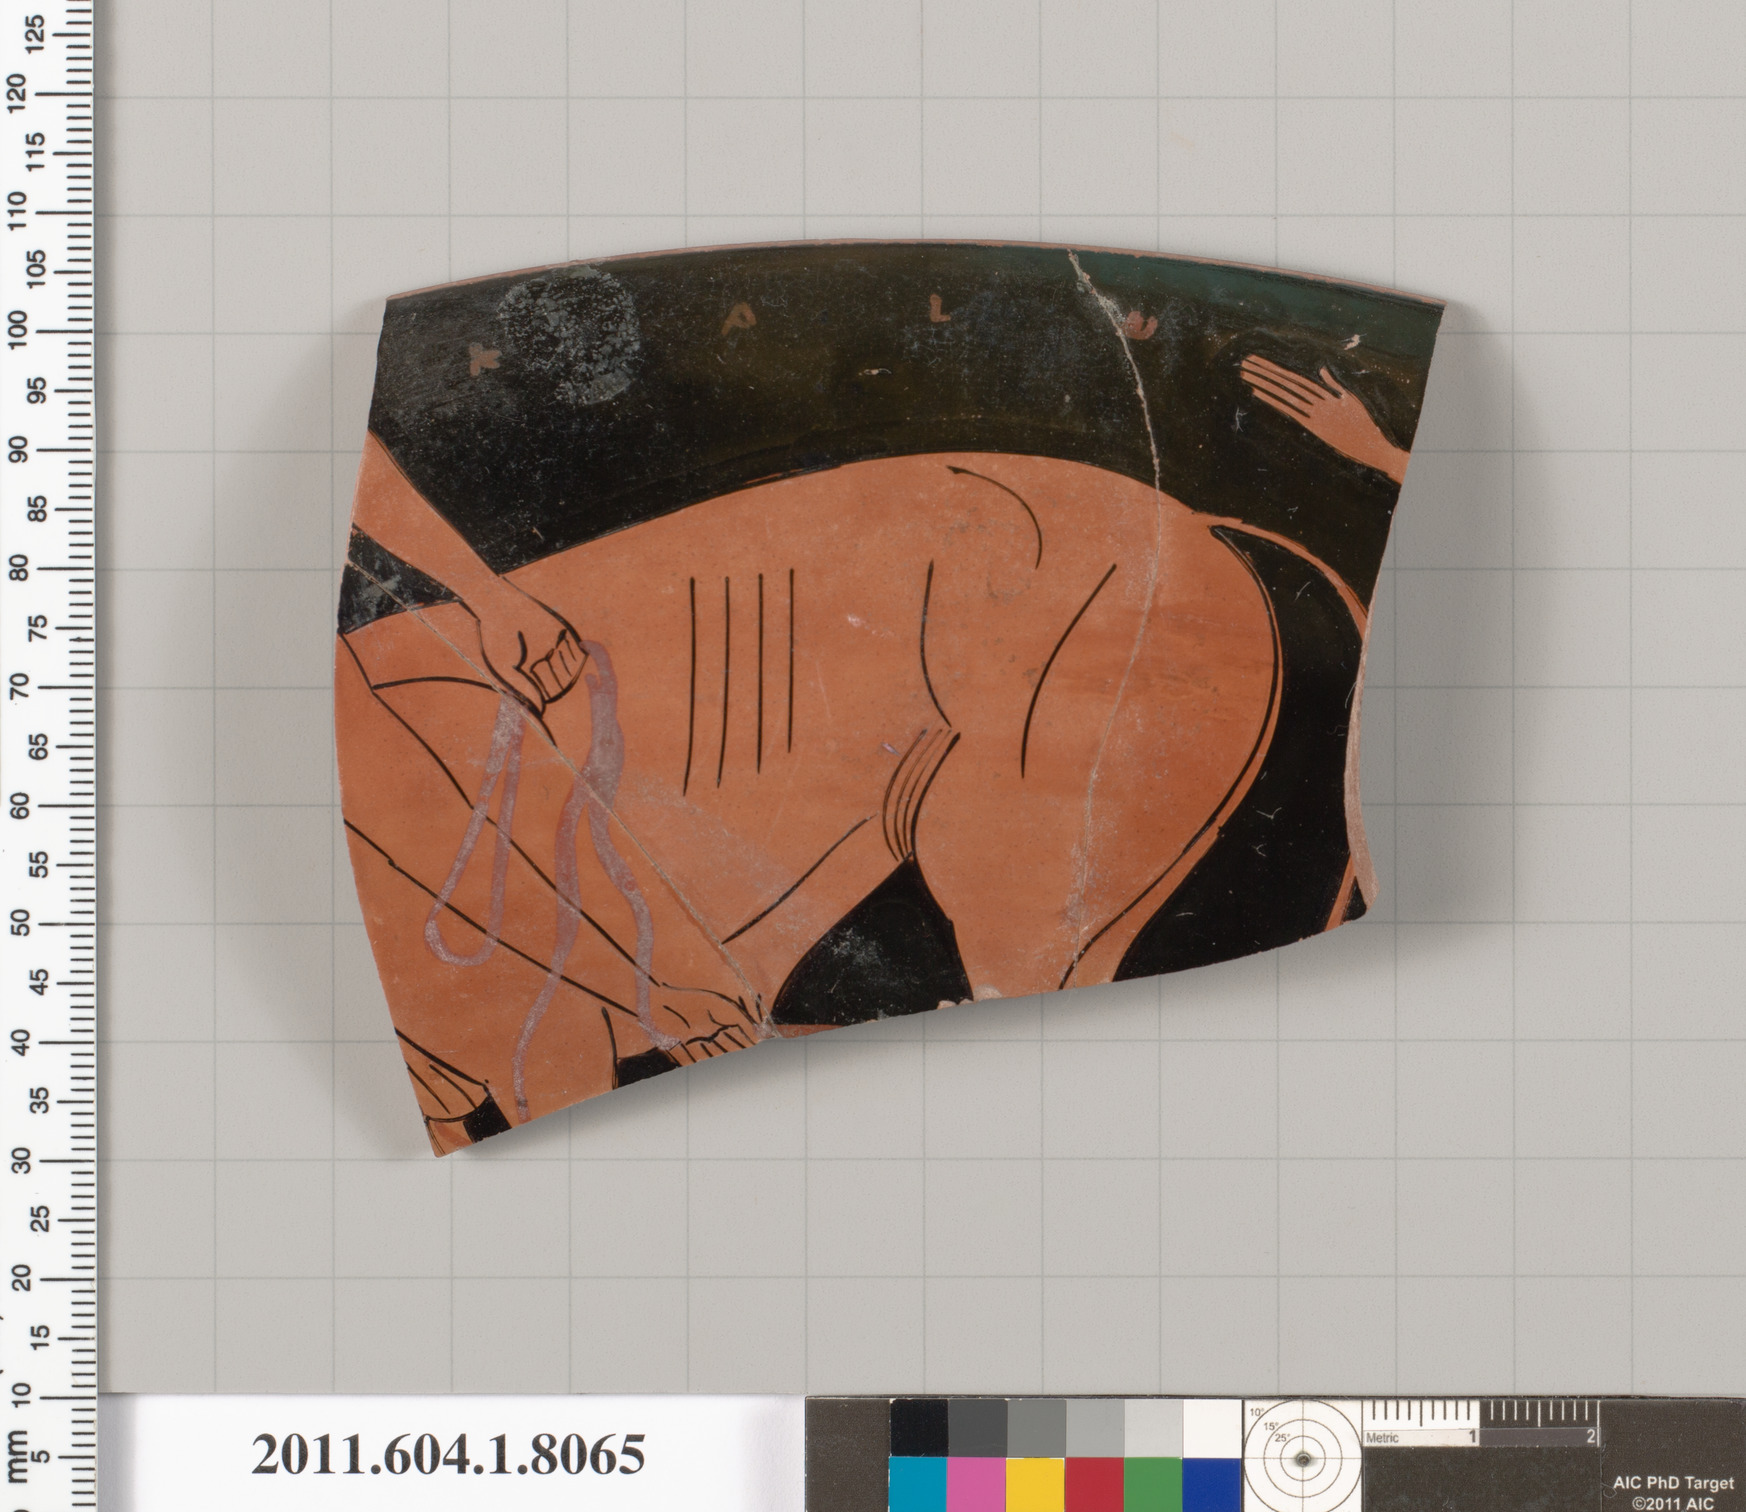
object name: kylix fragment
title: Terracotta rim fragment of a kylix (drinking cup)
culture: greek, attic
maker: euergides painter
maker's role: artist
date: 510-500 BCE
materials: terracotta